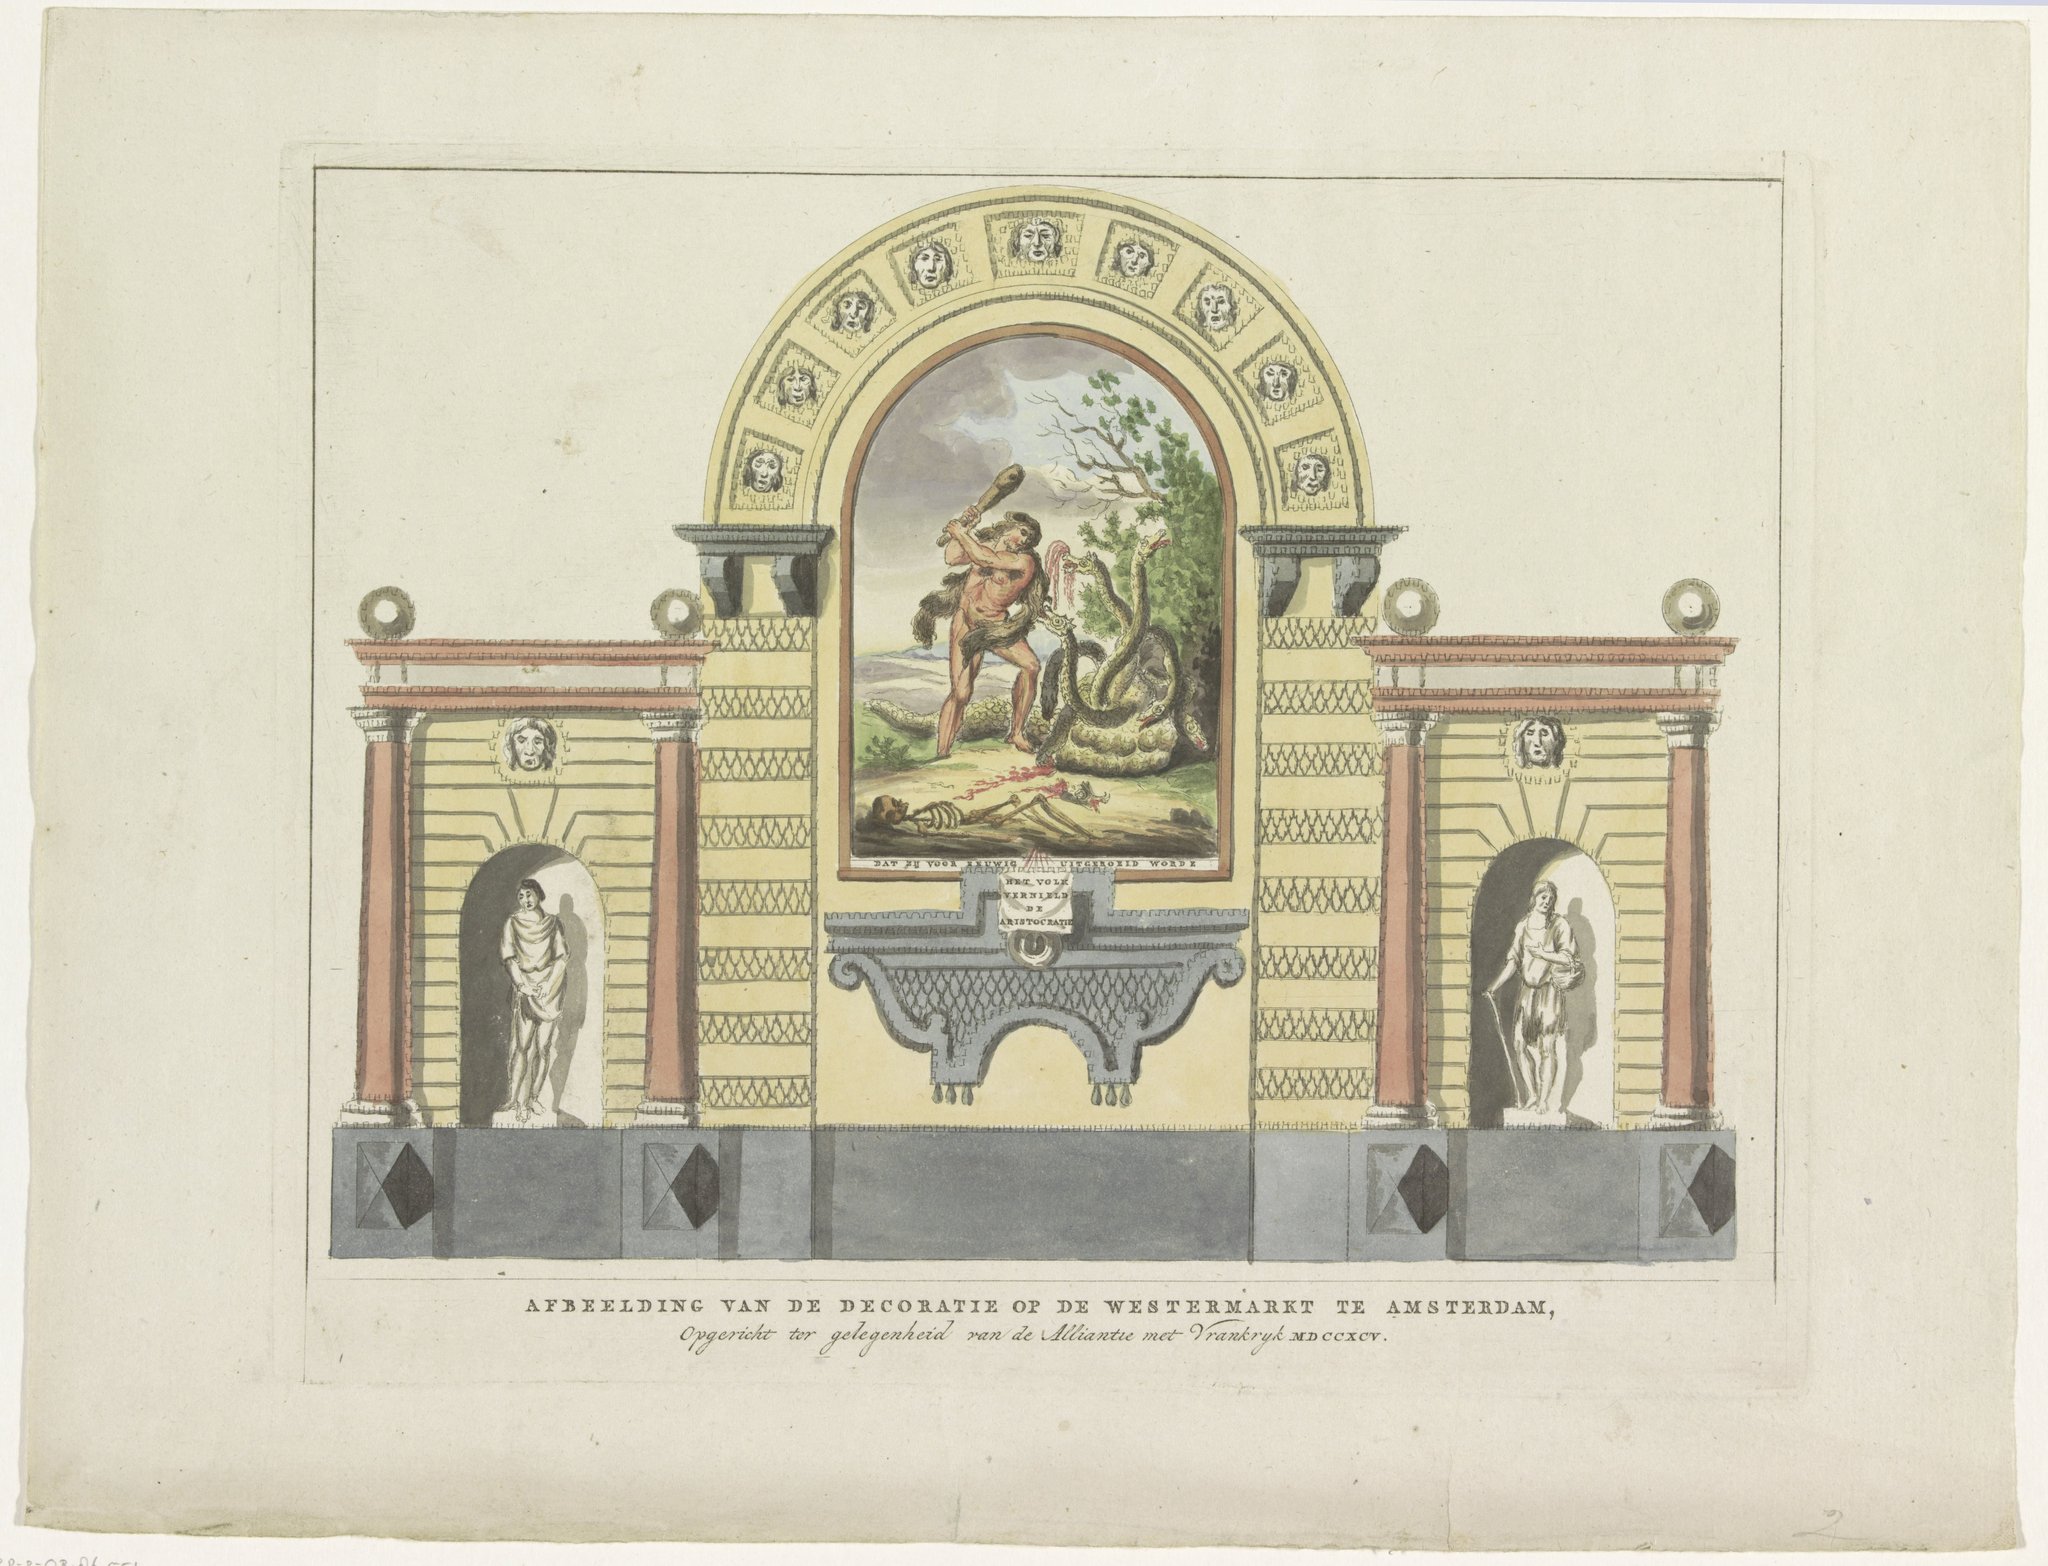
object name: print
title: Vernietiging der Aristocratie, decoratie op de Westermarkt, 1795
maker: Anonymous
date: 1795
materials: paper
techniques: etching, hand coloring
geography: netherlands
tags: (2) the hydra of lerna is killed by hercules, festivities on events of national importance (+ festive decoration ~ festive activities), amsterdam, alliance with france (1795)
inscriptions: collector's mark: Lugt 2228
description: De Vernietiging der Aristocratie, allegorische decoratie opgericht op de Westermarkt te Amsterdam bij het Alliantiefeest op 19 juni 1795. Hercules (het Nederlandse volk) verslaat de zevenkoppige hydra (aristocratie en familieregering). Onderdeel van een serie van tien platen.